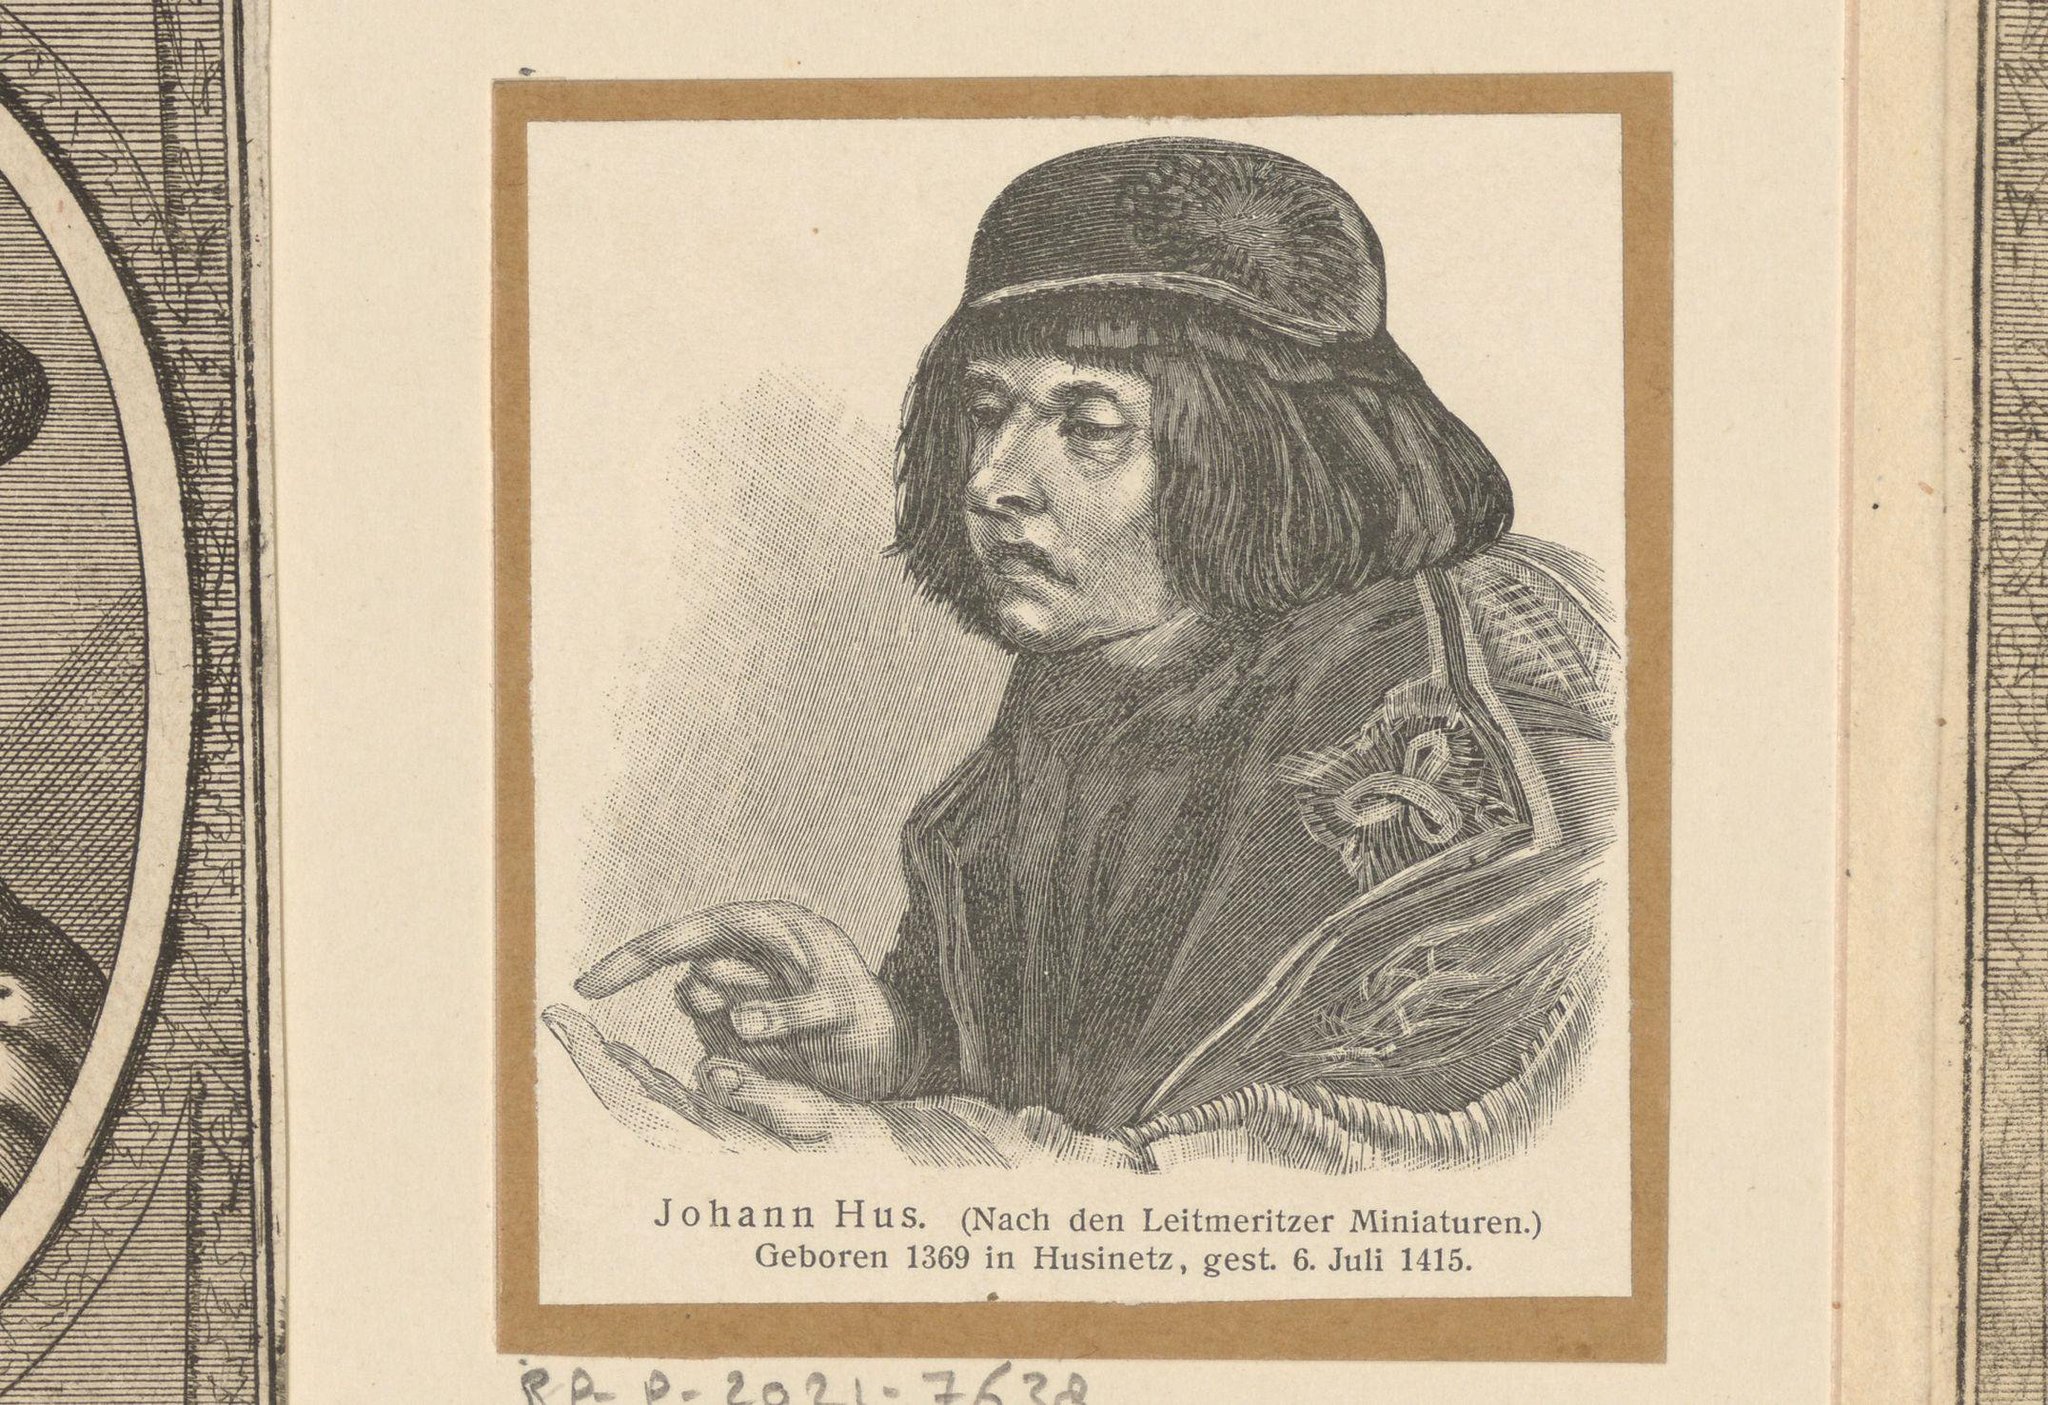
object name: print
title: Portret van Johannes Hus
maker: Anonymous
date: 1900-1924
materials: paper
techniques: letterpress printing, engraving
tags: theologian, historical persons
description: Prent mogelijk uit een latere editie van Meysers Grosses Konversations-Lexikon.